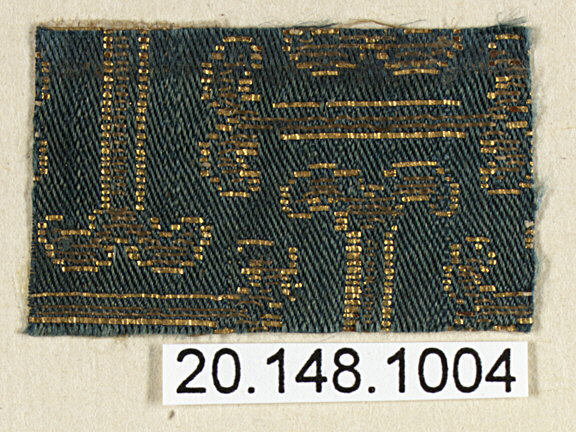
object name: piece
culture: japanese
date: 1701-1800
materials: silk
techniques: compound weave